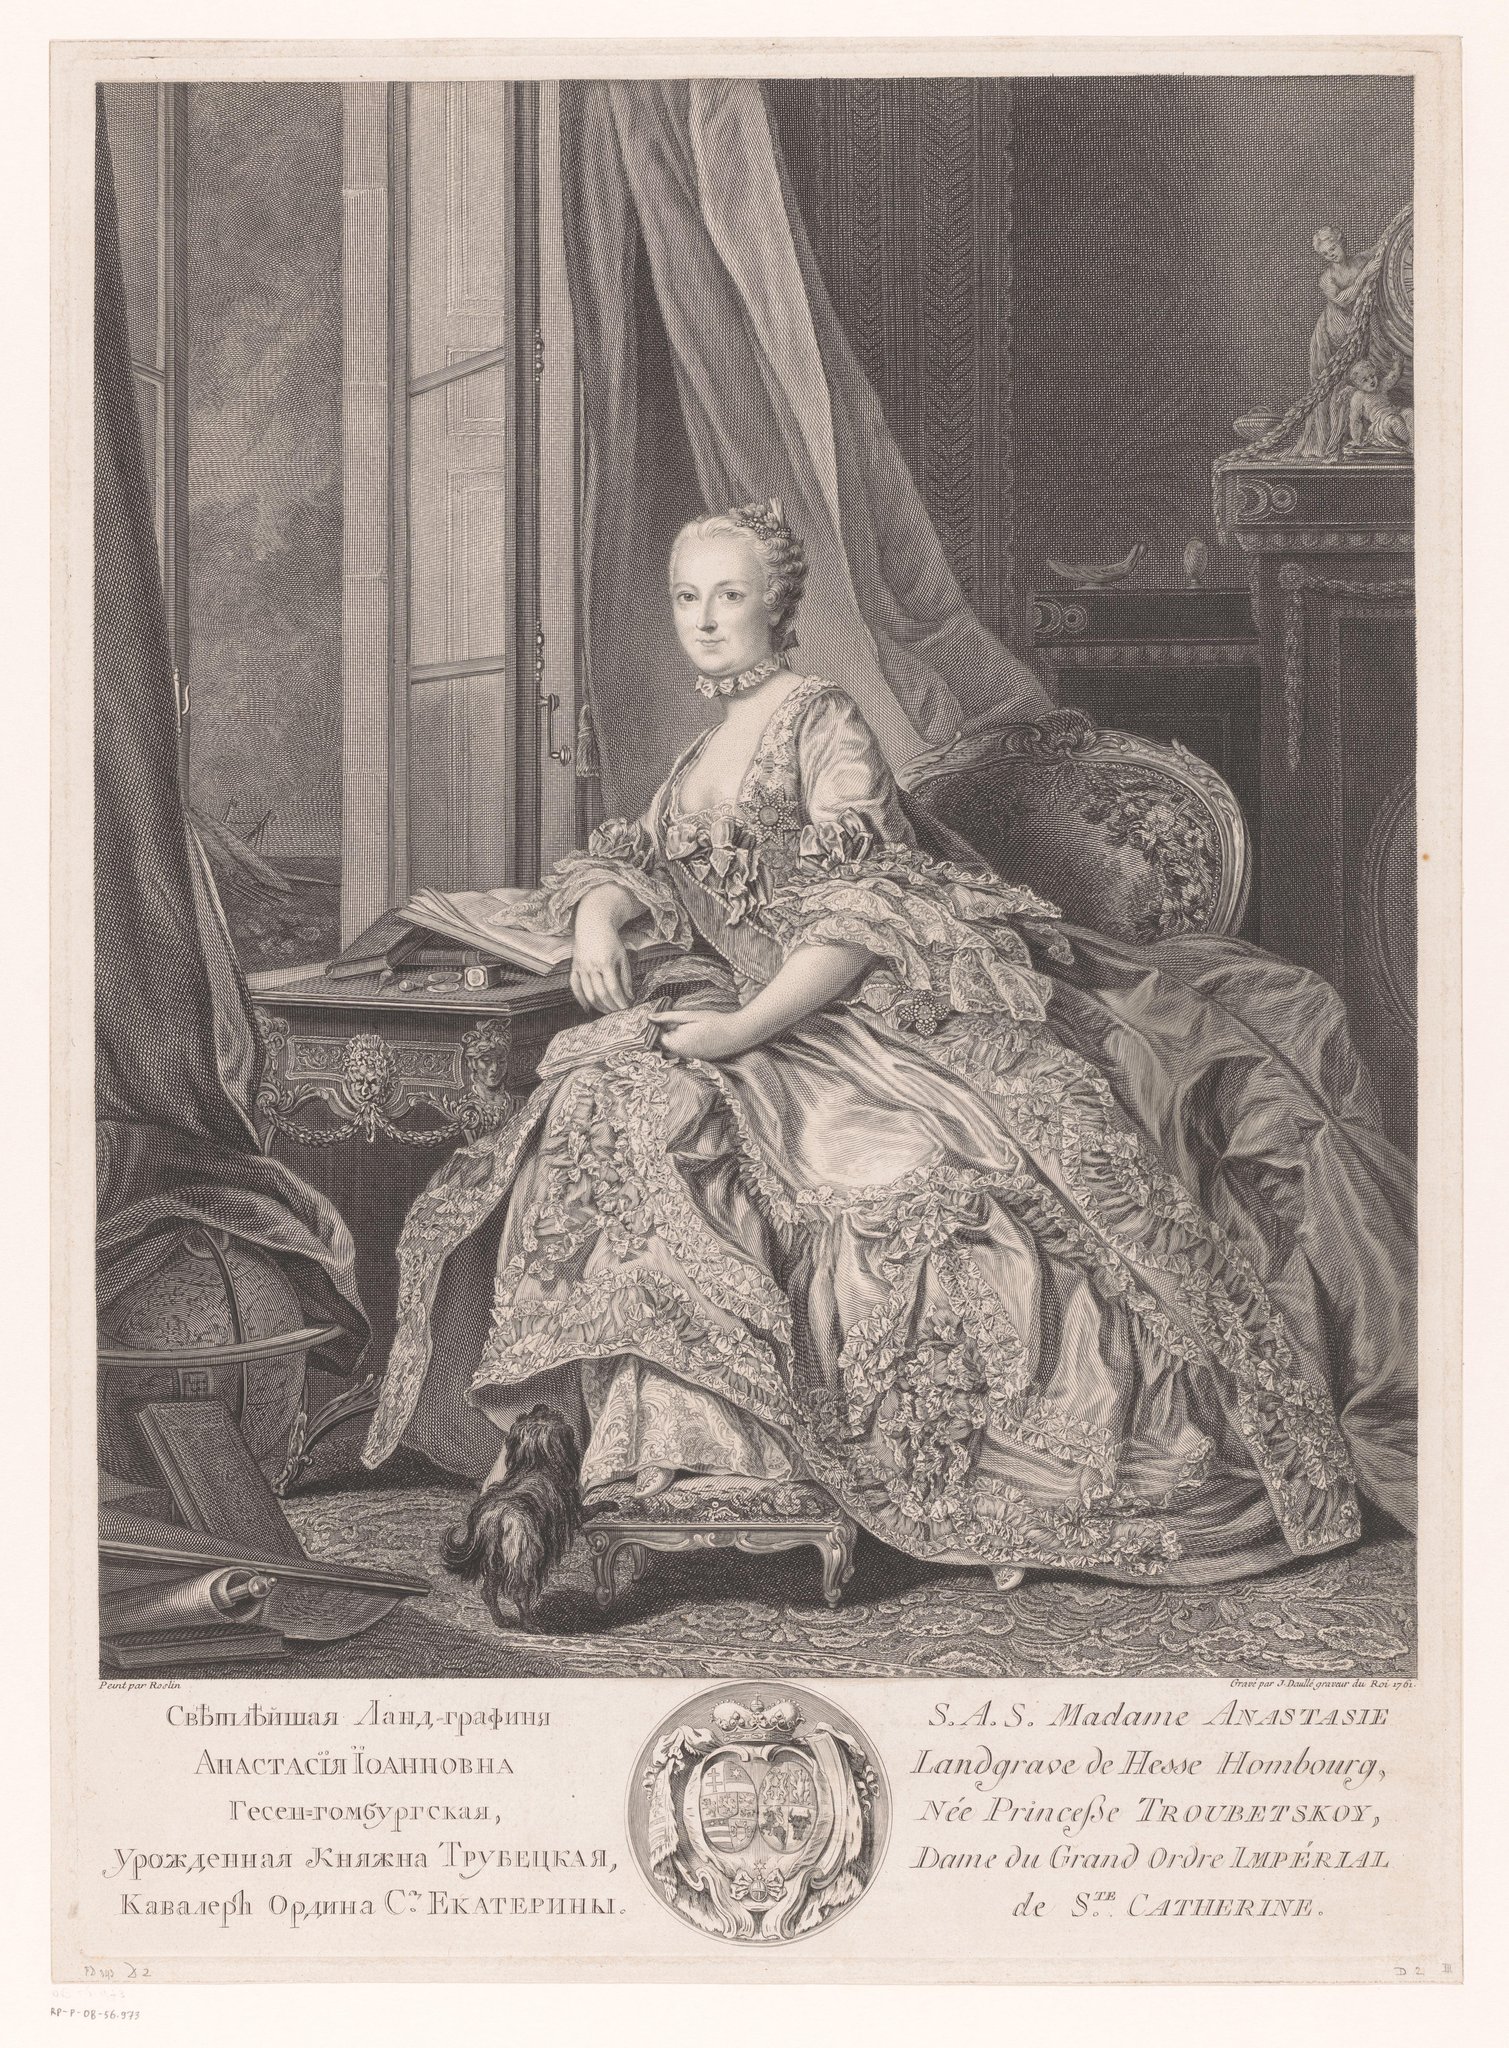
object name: print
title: Portret van mevrouw Anastasie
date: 1761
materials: paper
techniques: engraving, etching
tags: historical persons - bb - woman, armorial bearing, heraldry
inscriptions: collector's mark: Lugt 240